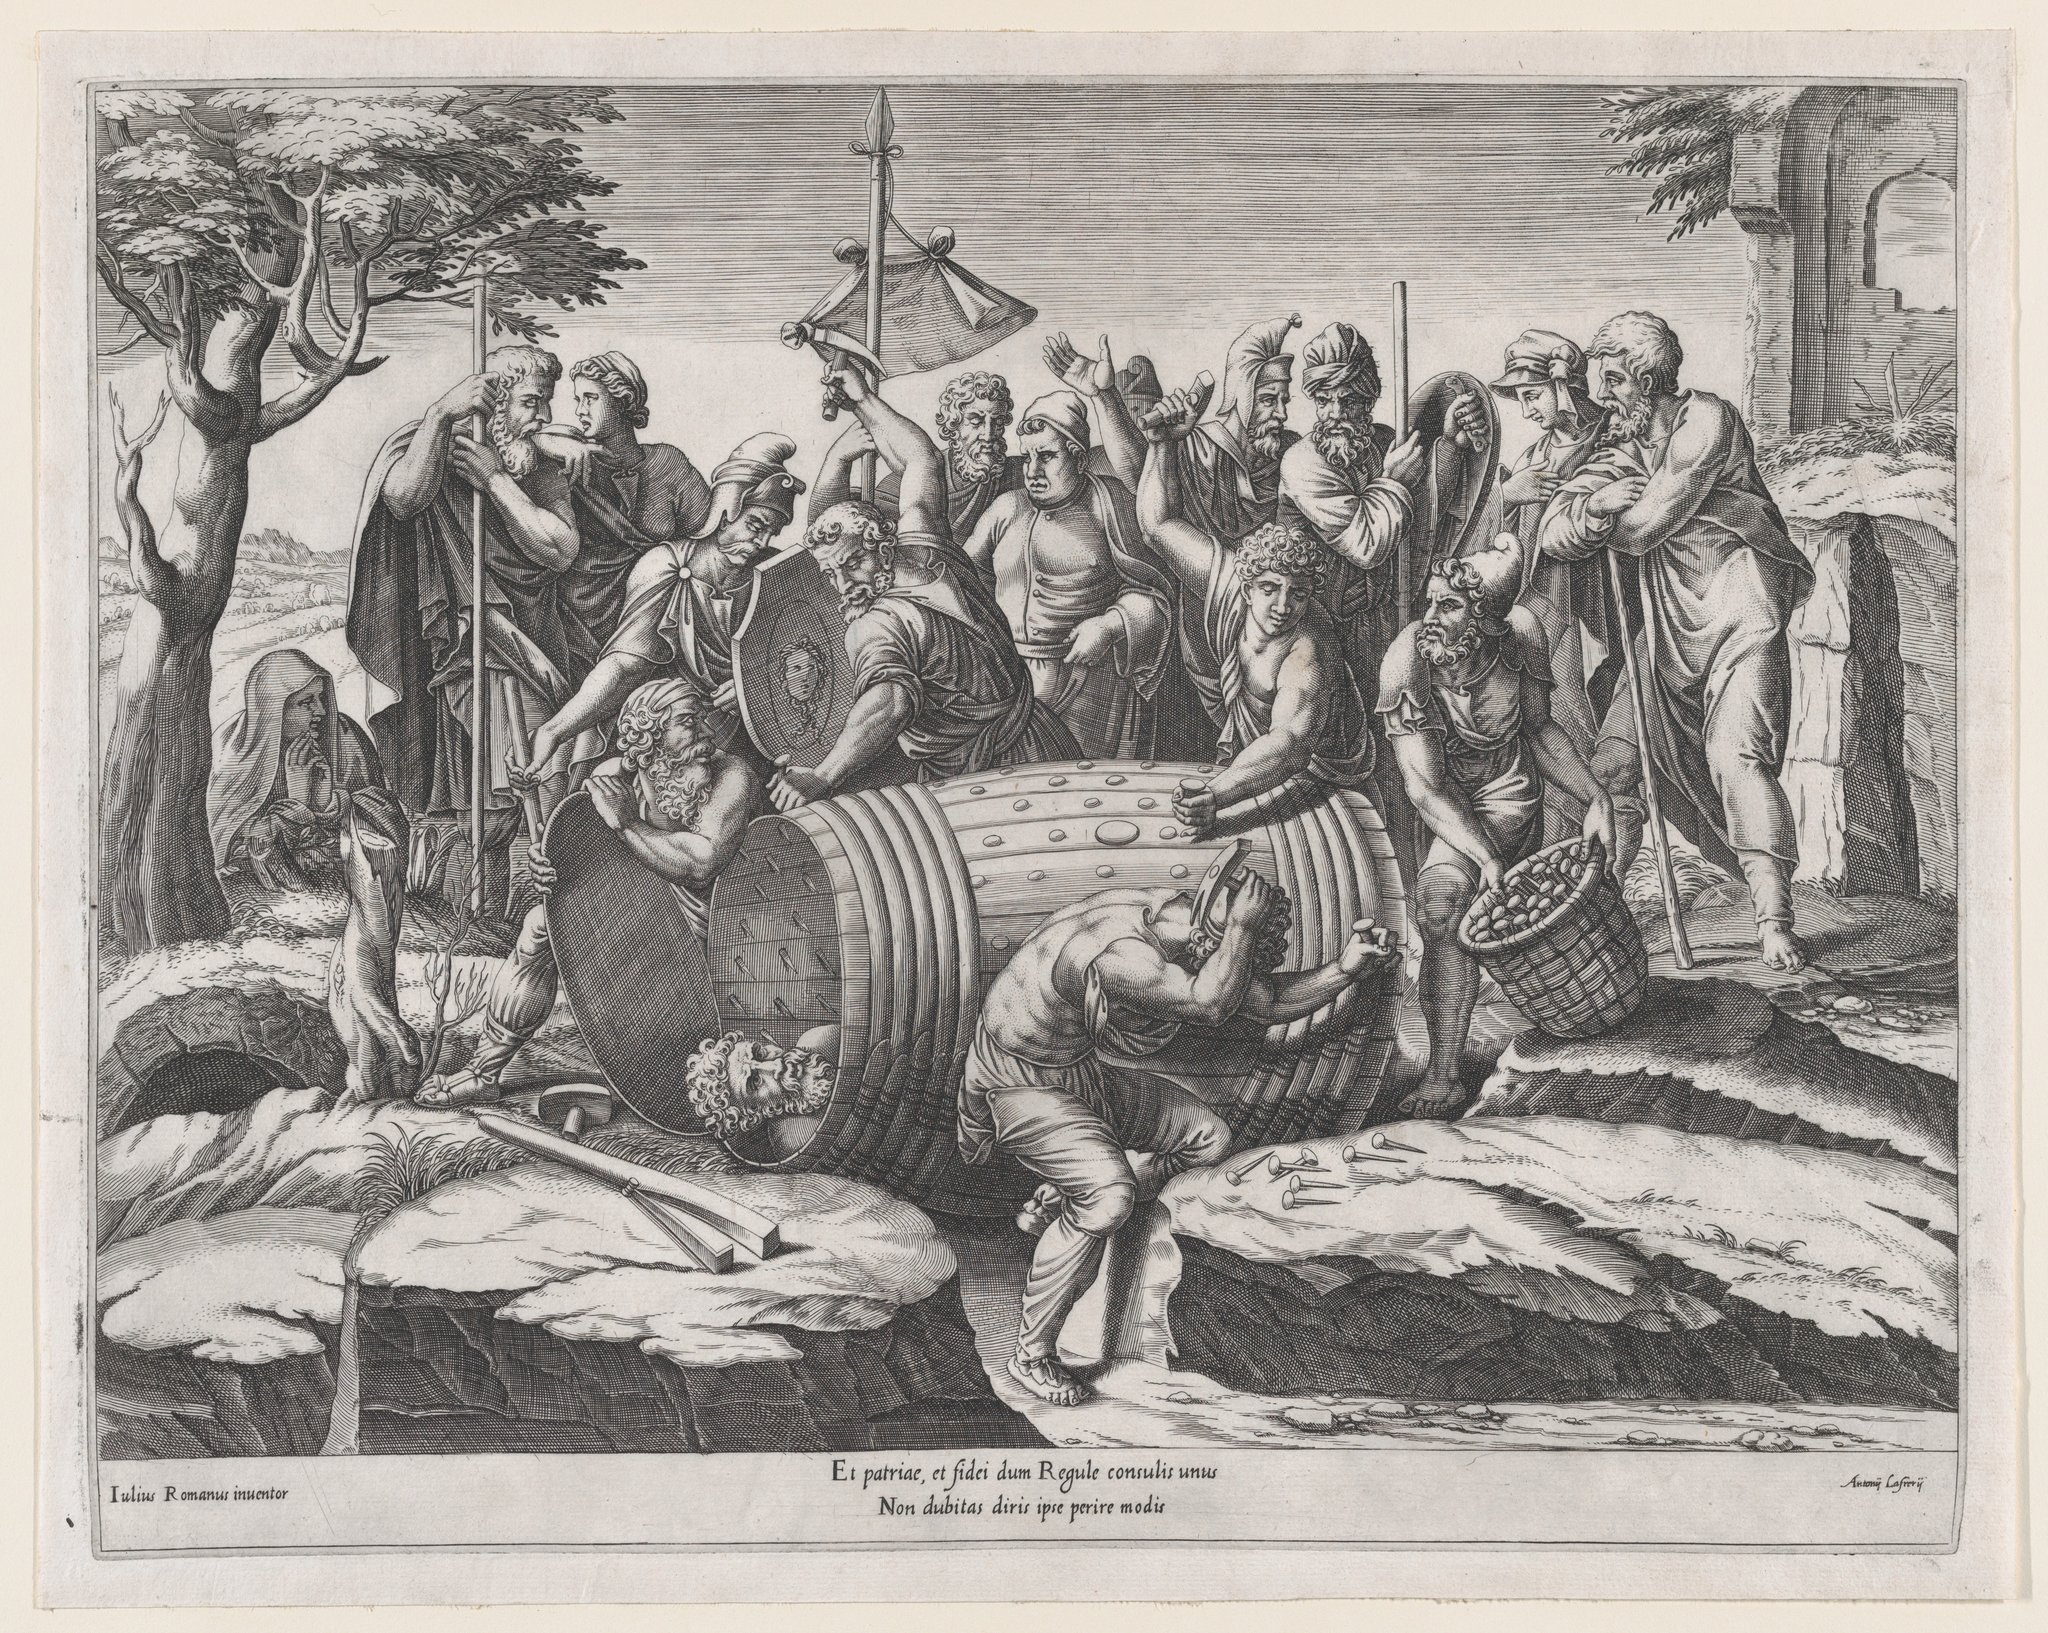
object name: print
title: Attilius Regulus in a Barrel, from "Speculum Romanae Magnificentiae"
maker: diana scultori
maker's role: artist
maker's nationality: italian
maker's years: 1535-1588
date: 1567-1600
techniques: engraving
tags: men,barrels